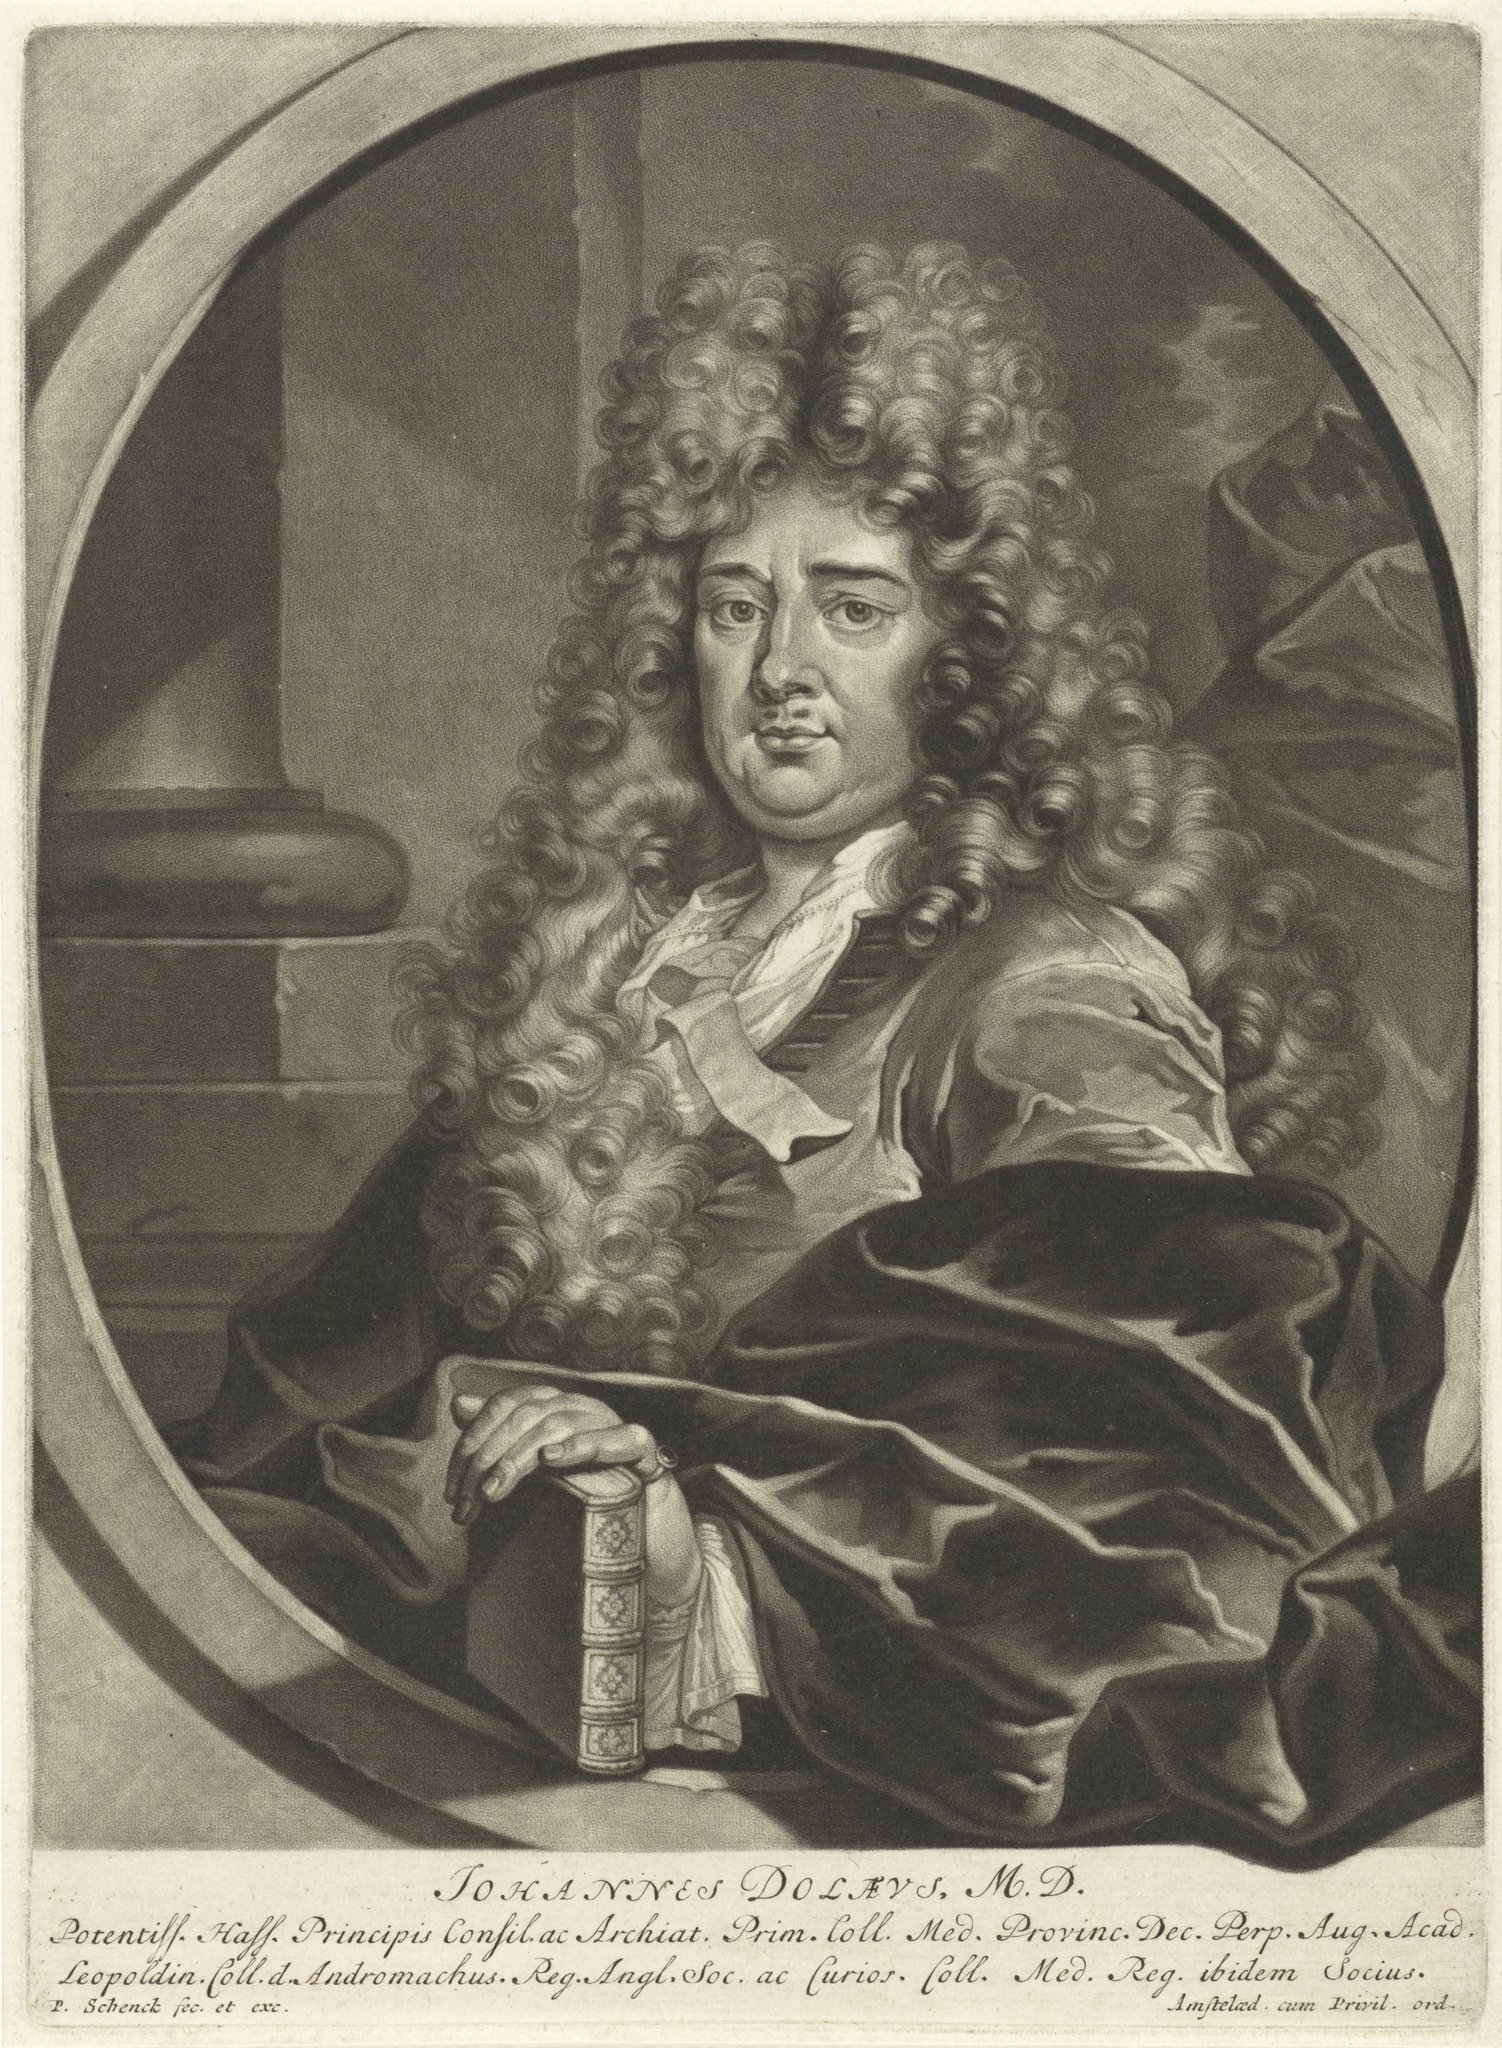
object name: print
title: Portret van Johannes Dolaeus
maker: pieter schenk (i)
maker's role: print maker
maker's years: 1660-1711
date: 1670-1713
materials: paper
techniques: engraving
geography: amsterdam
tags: book, wig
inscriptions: collector's mark: Lugt 2228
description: Johannes Dolaeus, lijfarts van Albertine van Nassau. Hij draagt een lange krulpruik en laat zijn hand rusten op een boek.